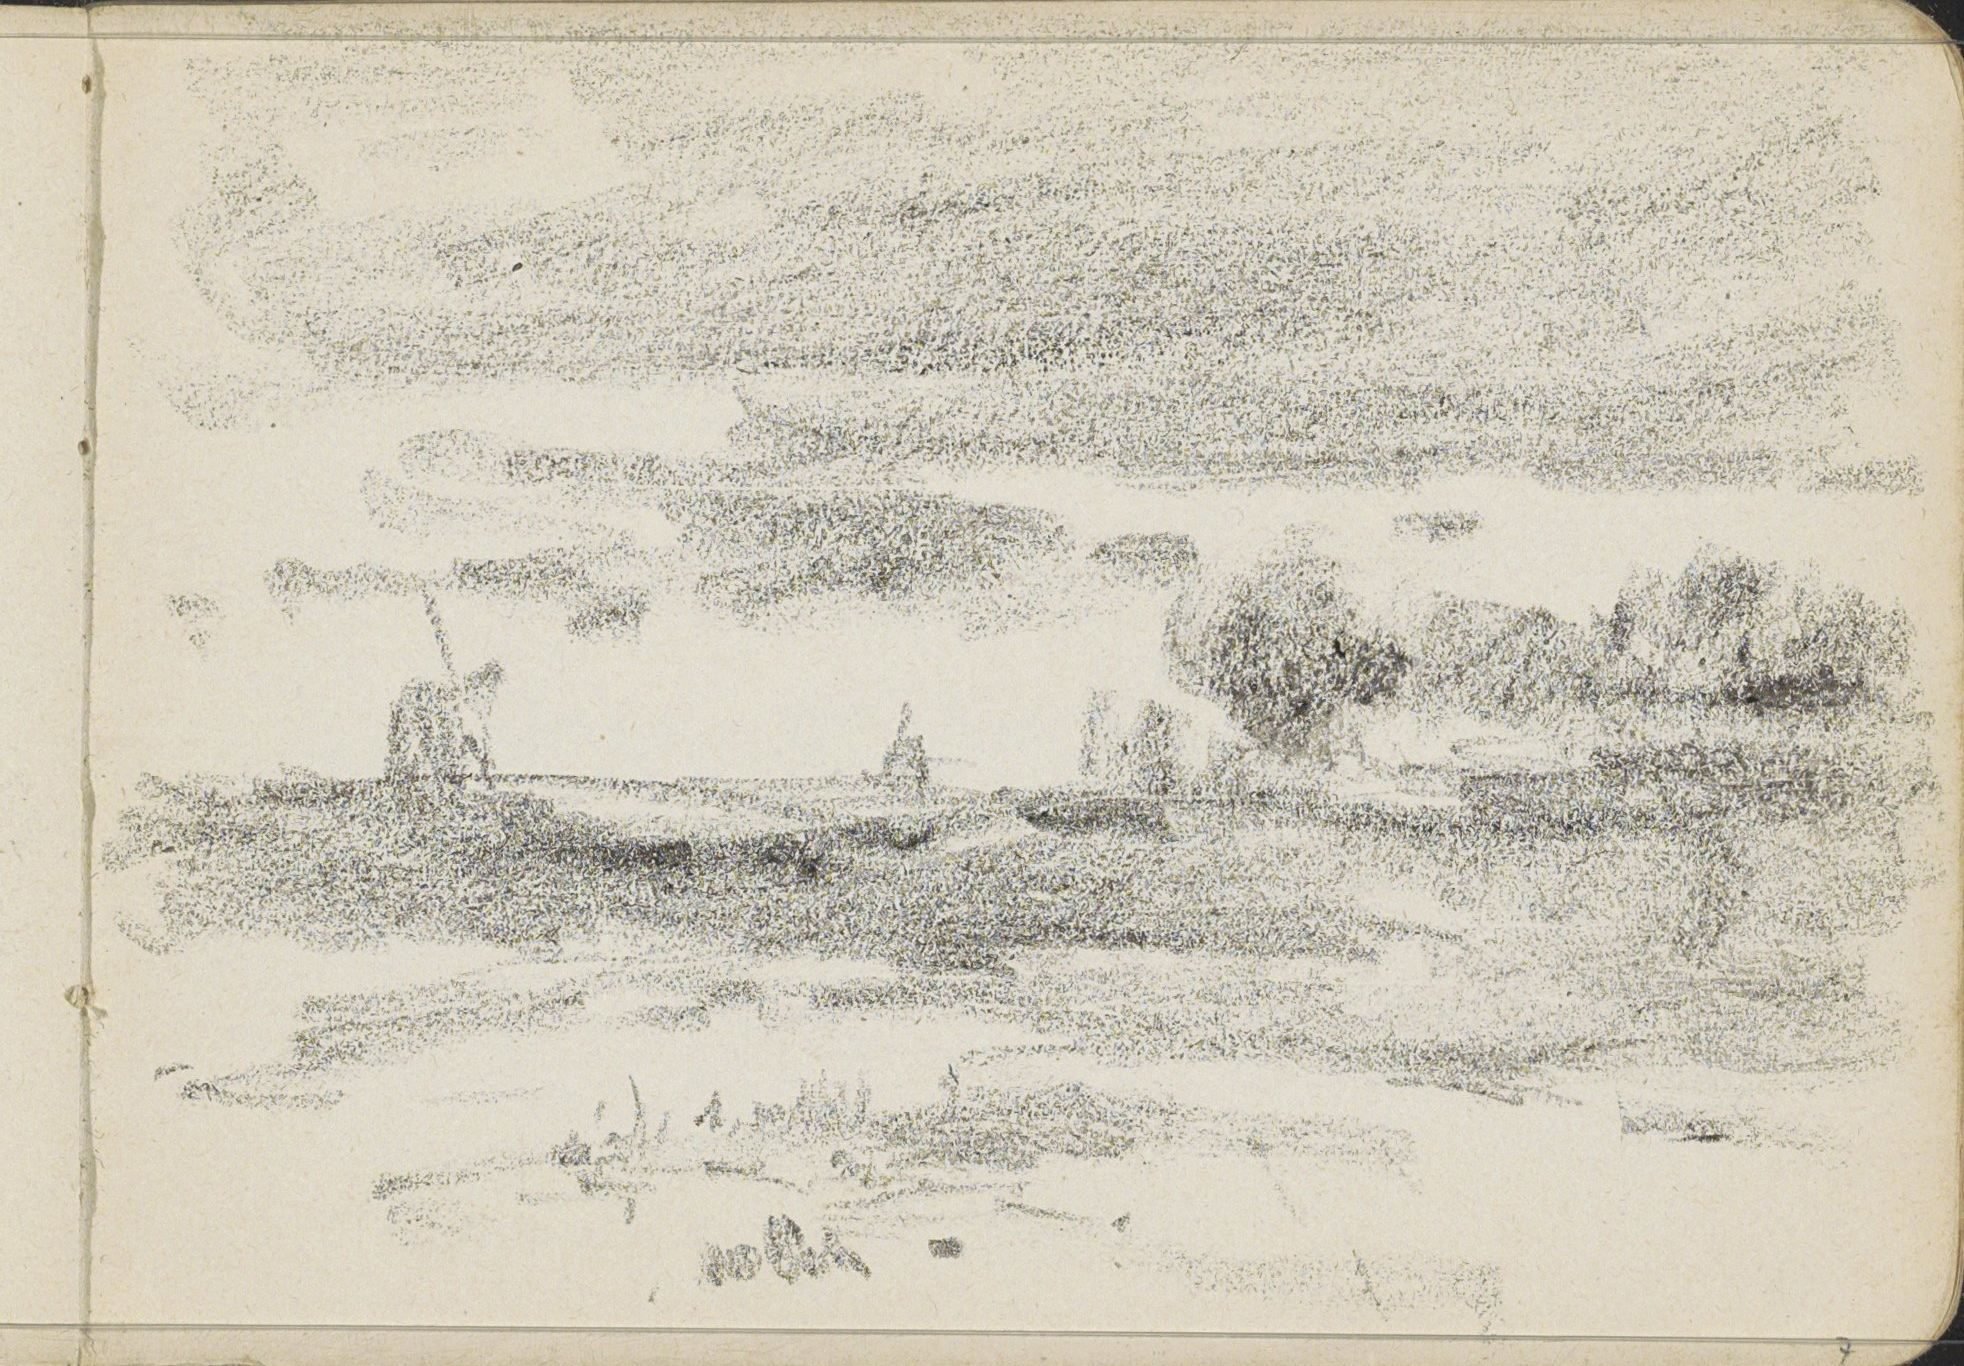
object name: sketchbook leaf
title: Landschap met molens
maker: willem cornelis rip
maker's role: draughtsman, painter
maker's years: 1856-1922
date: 1905-1910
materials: chalk, paper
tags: windmill in landscape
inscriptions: date: ‘10 Oct’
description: Blad 7 recto uit een schetsboek met 42 bladen.